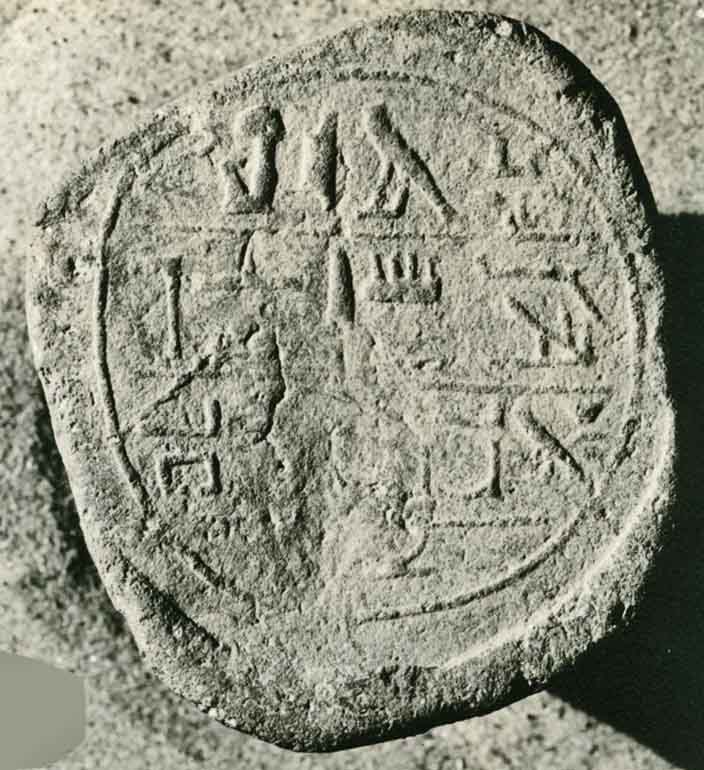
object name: cone, abemweskhet, nefertari, granary of amun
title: Funerary Cone of Abemweskhet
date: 1550-1295 BCE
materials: pottery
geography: egypt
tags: hieroglyphs